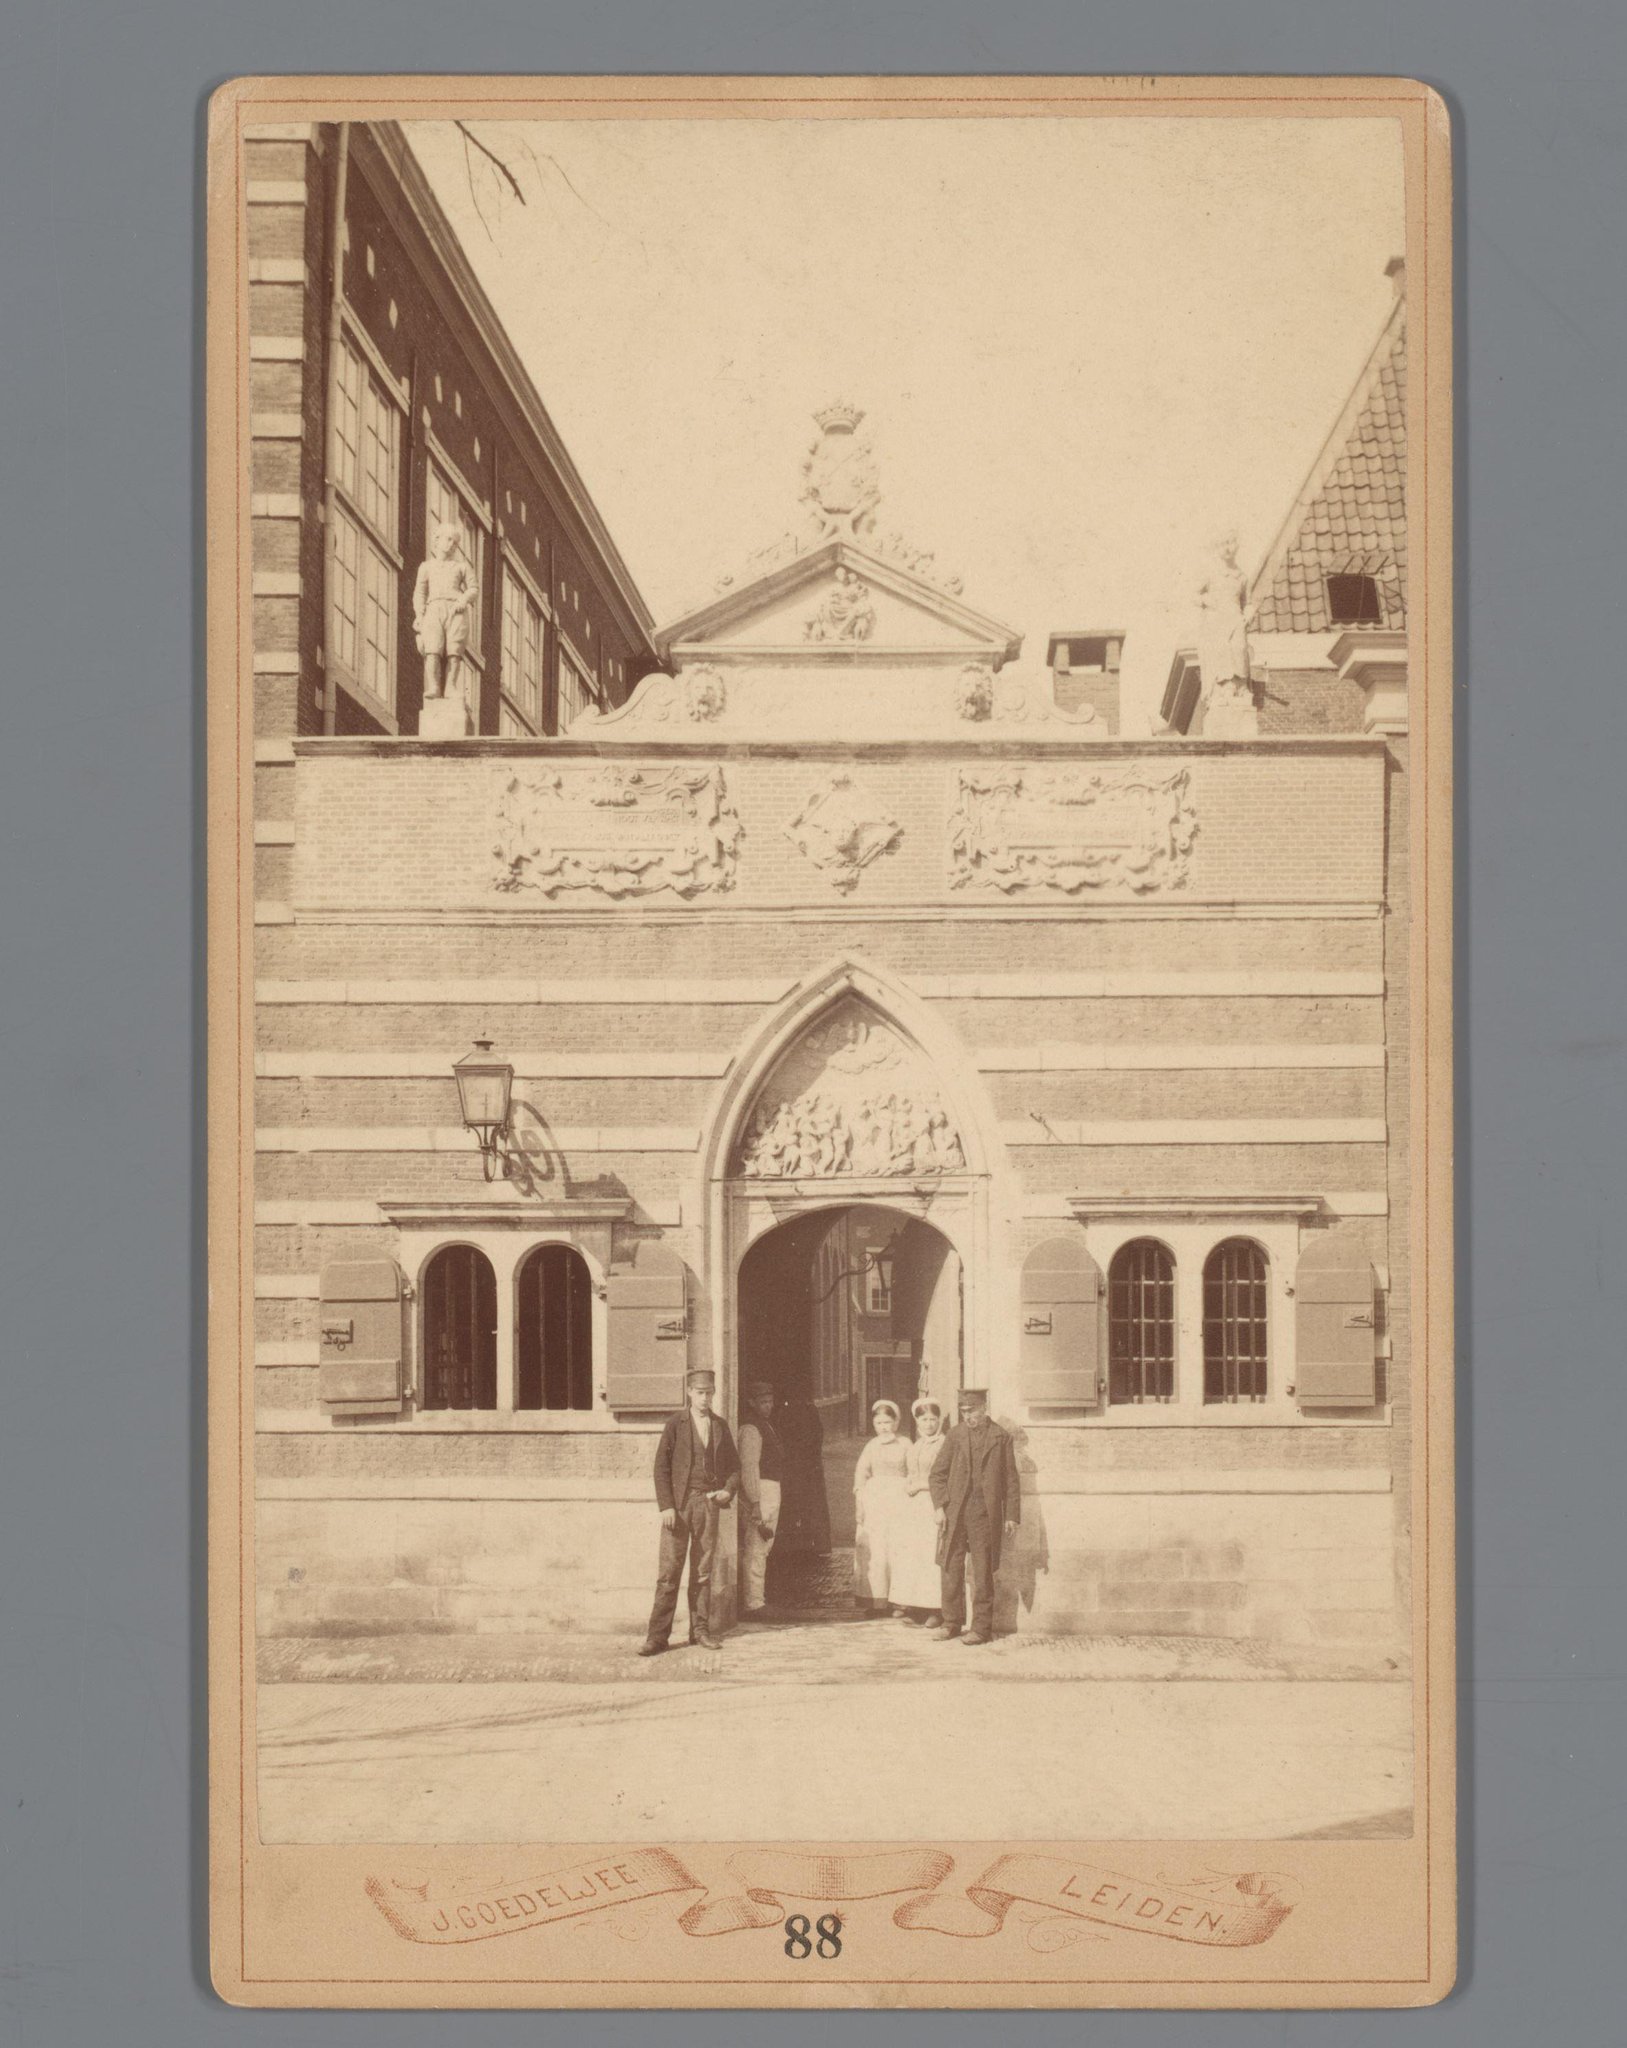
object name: cabinet photograph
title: Ingang van het weeshuis te Leiden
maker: jan goedeljee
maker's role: fotograaf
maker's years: 1824-1905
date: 1879-1915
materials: cardboard, photographic support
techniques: albumen print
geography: leiden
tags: orphanage, leiden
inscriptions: inscription: ‘J. Goedeljee (...) Leiden/ Hoogeword 160/ naby de Plantage’, inscription: ‘J. Goedeljee/ Leiden/ 88’, annotation: ‘Ingang Weeshuis/ Leiden’